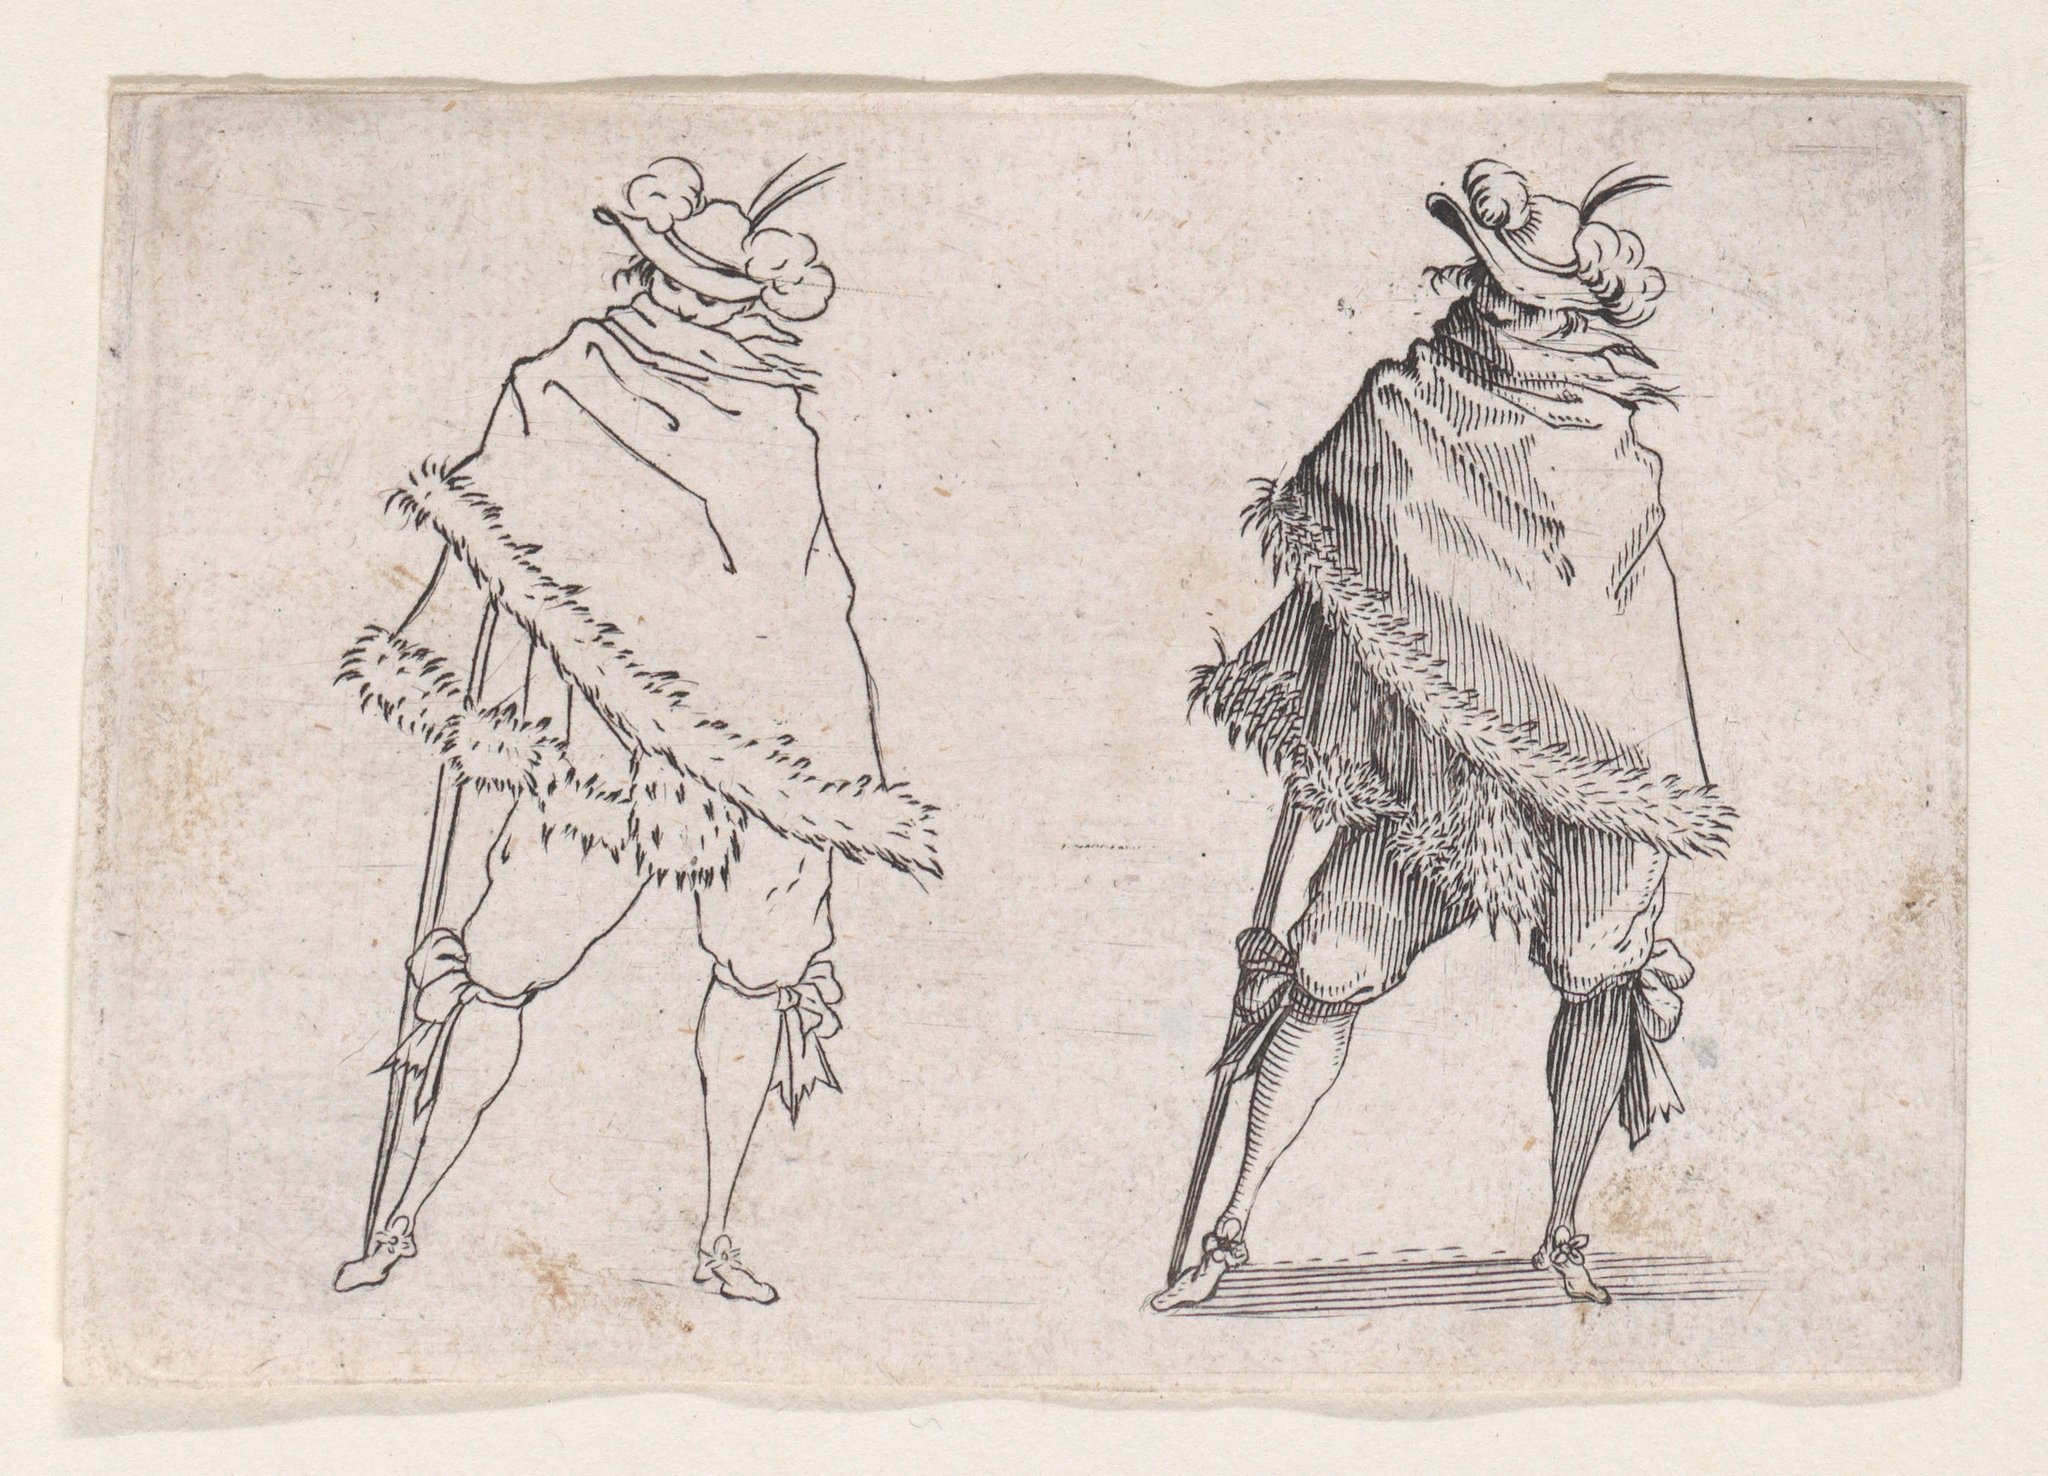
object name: print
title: Reverse Copy of L'Homme Enroulé dans son Manteau (Man Wrapped in his Mantle), from "Les Caprices" Series A, The Florence Set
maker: Anonymous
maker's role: artist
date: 1601-1700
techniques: etching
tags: men